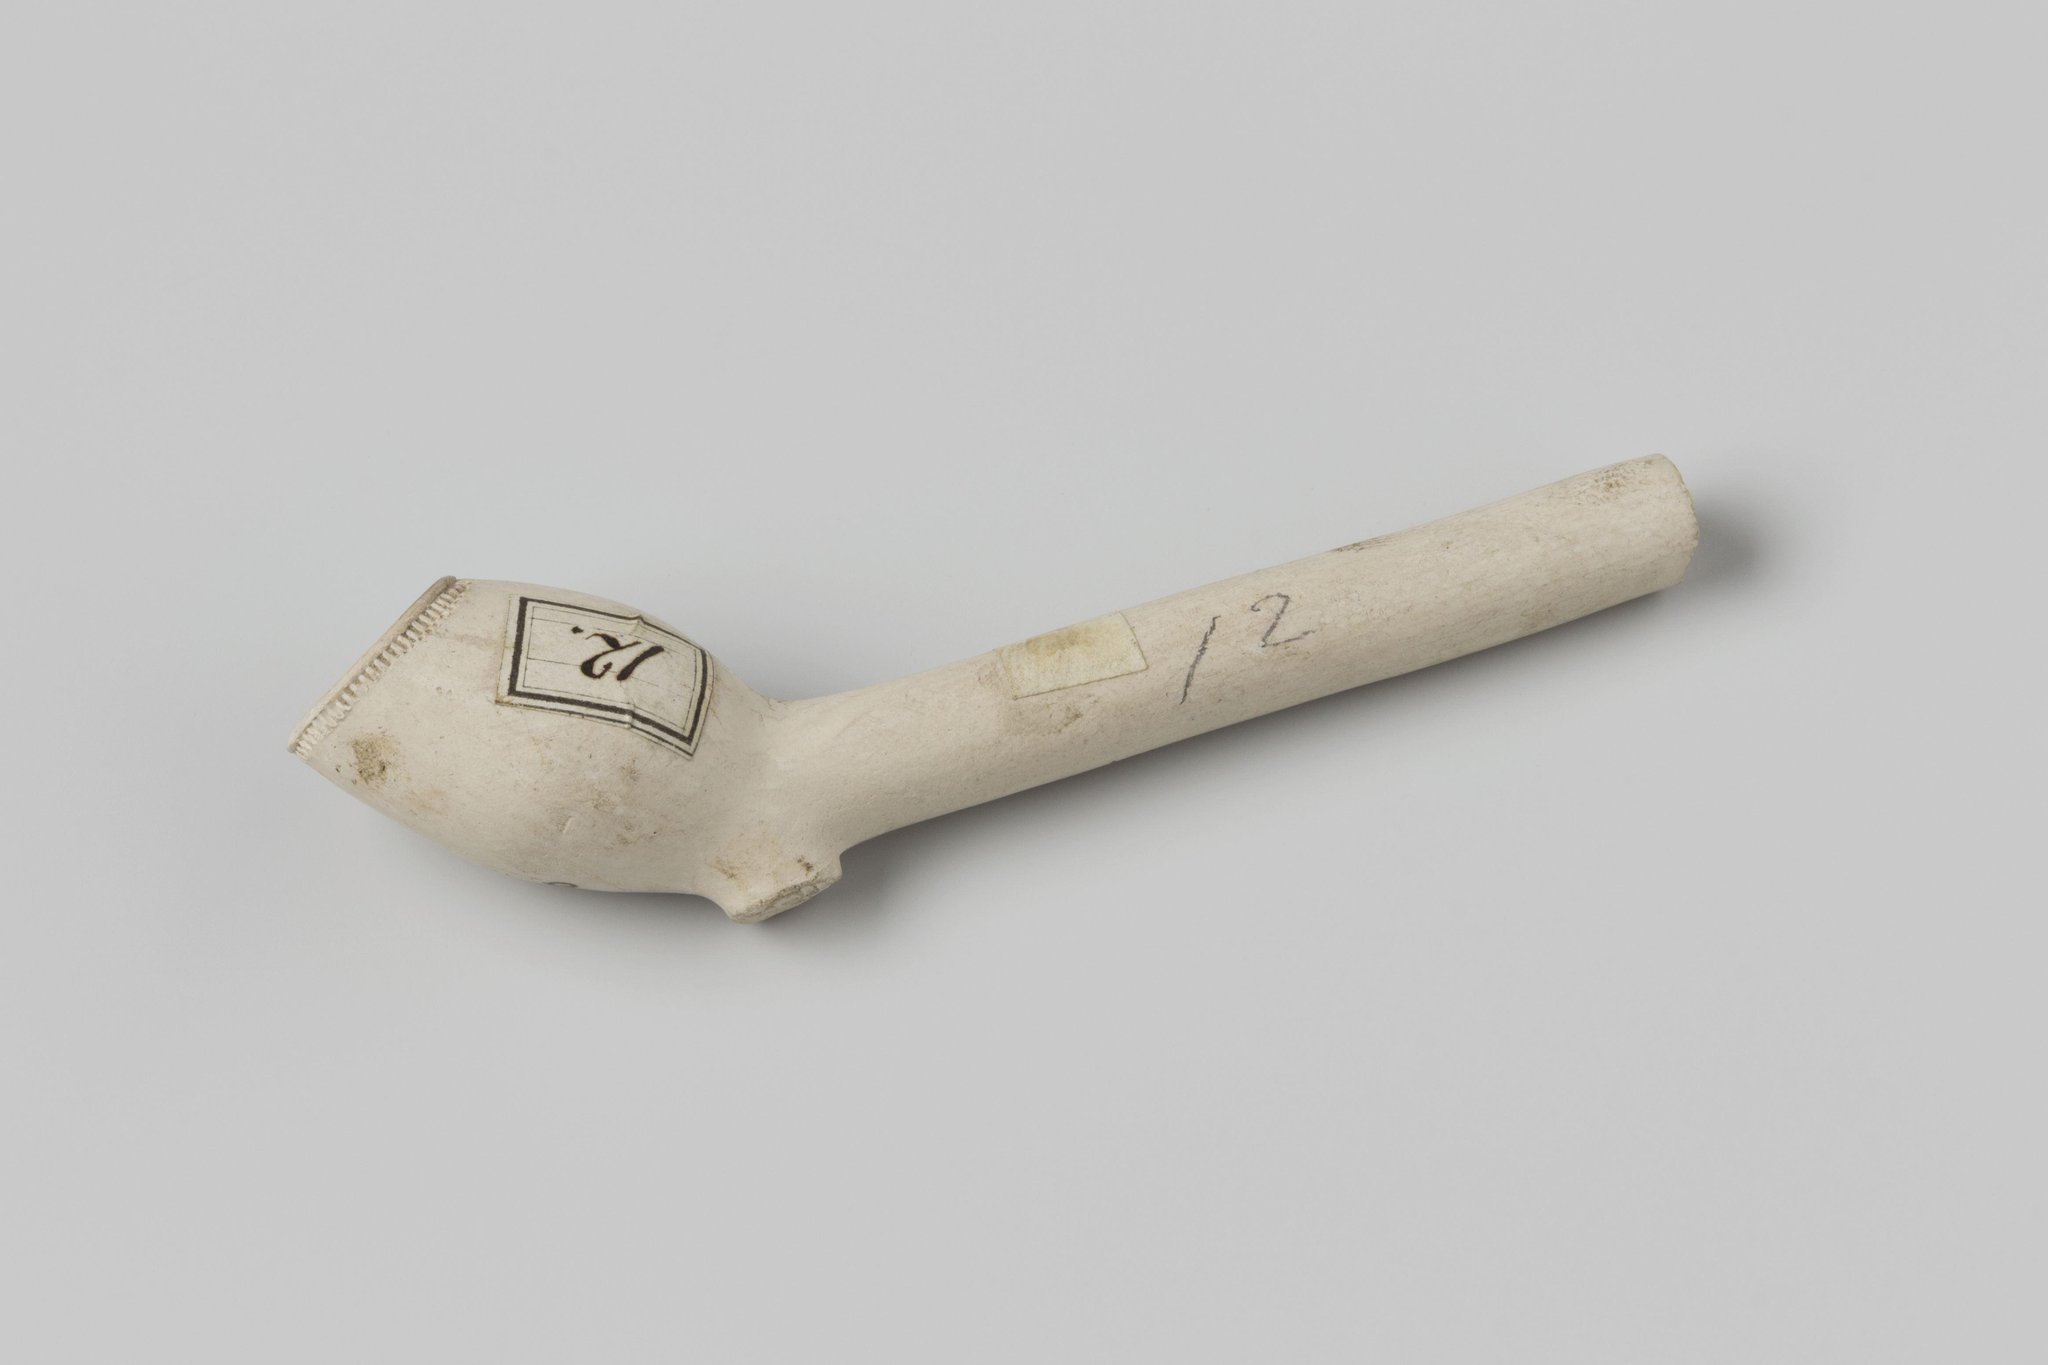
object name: pipe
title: Pijp van aarde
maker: Anonymous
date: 1400-1950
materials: earthenware, clay